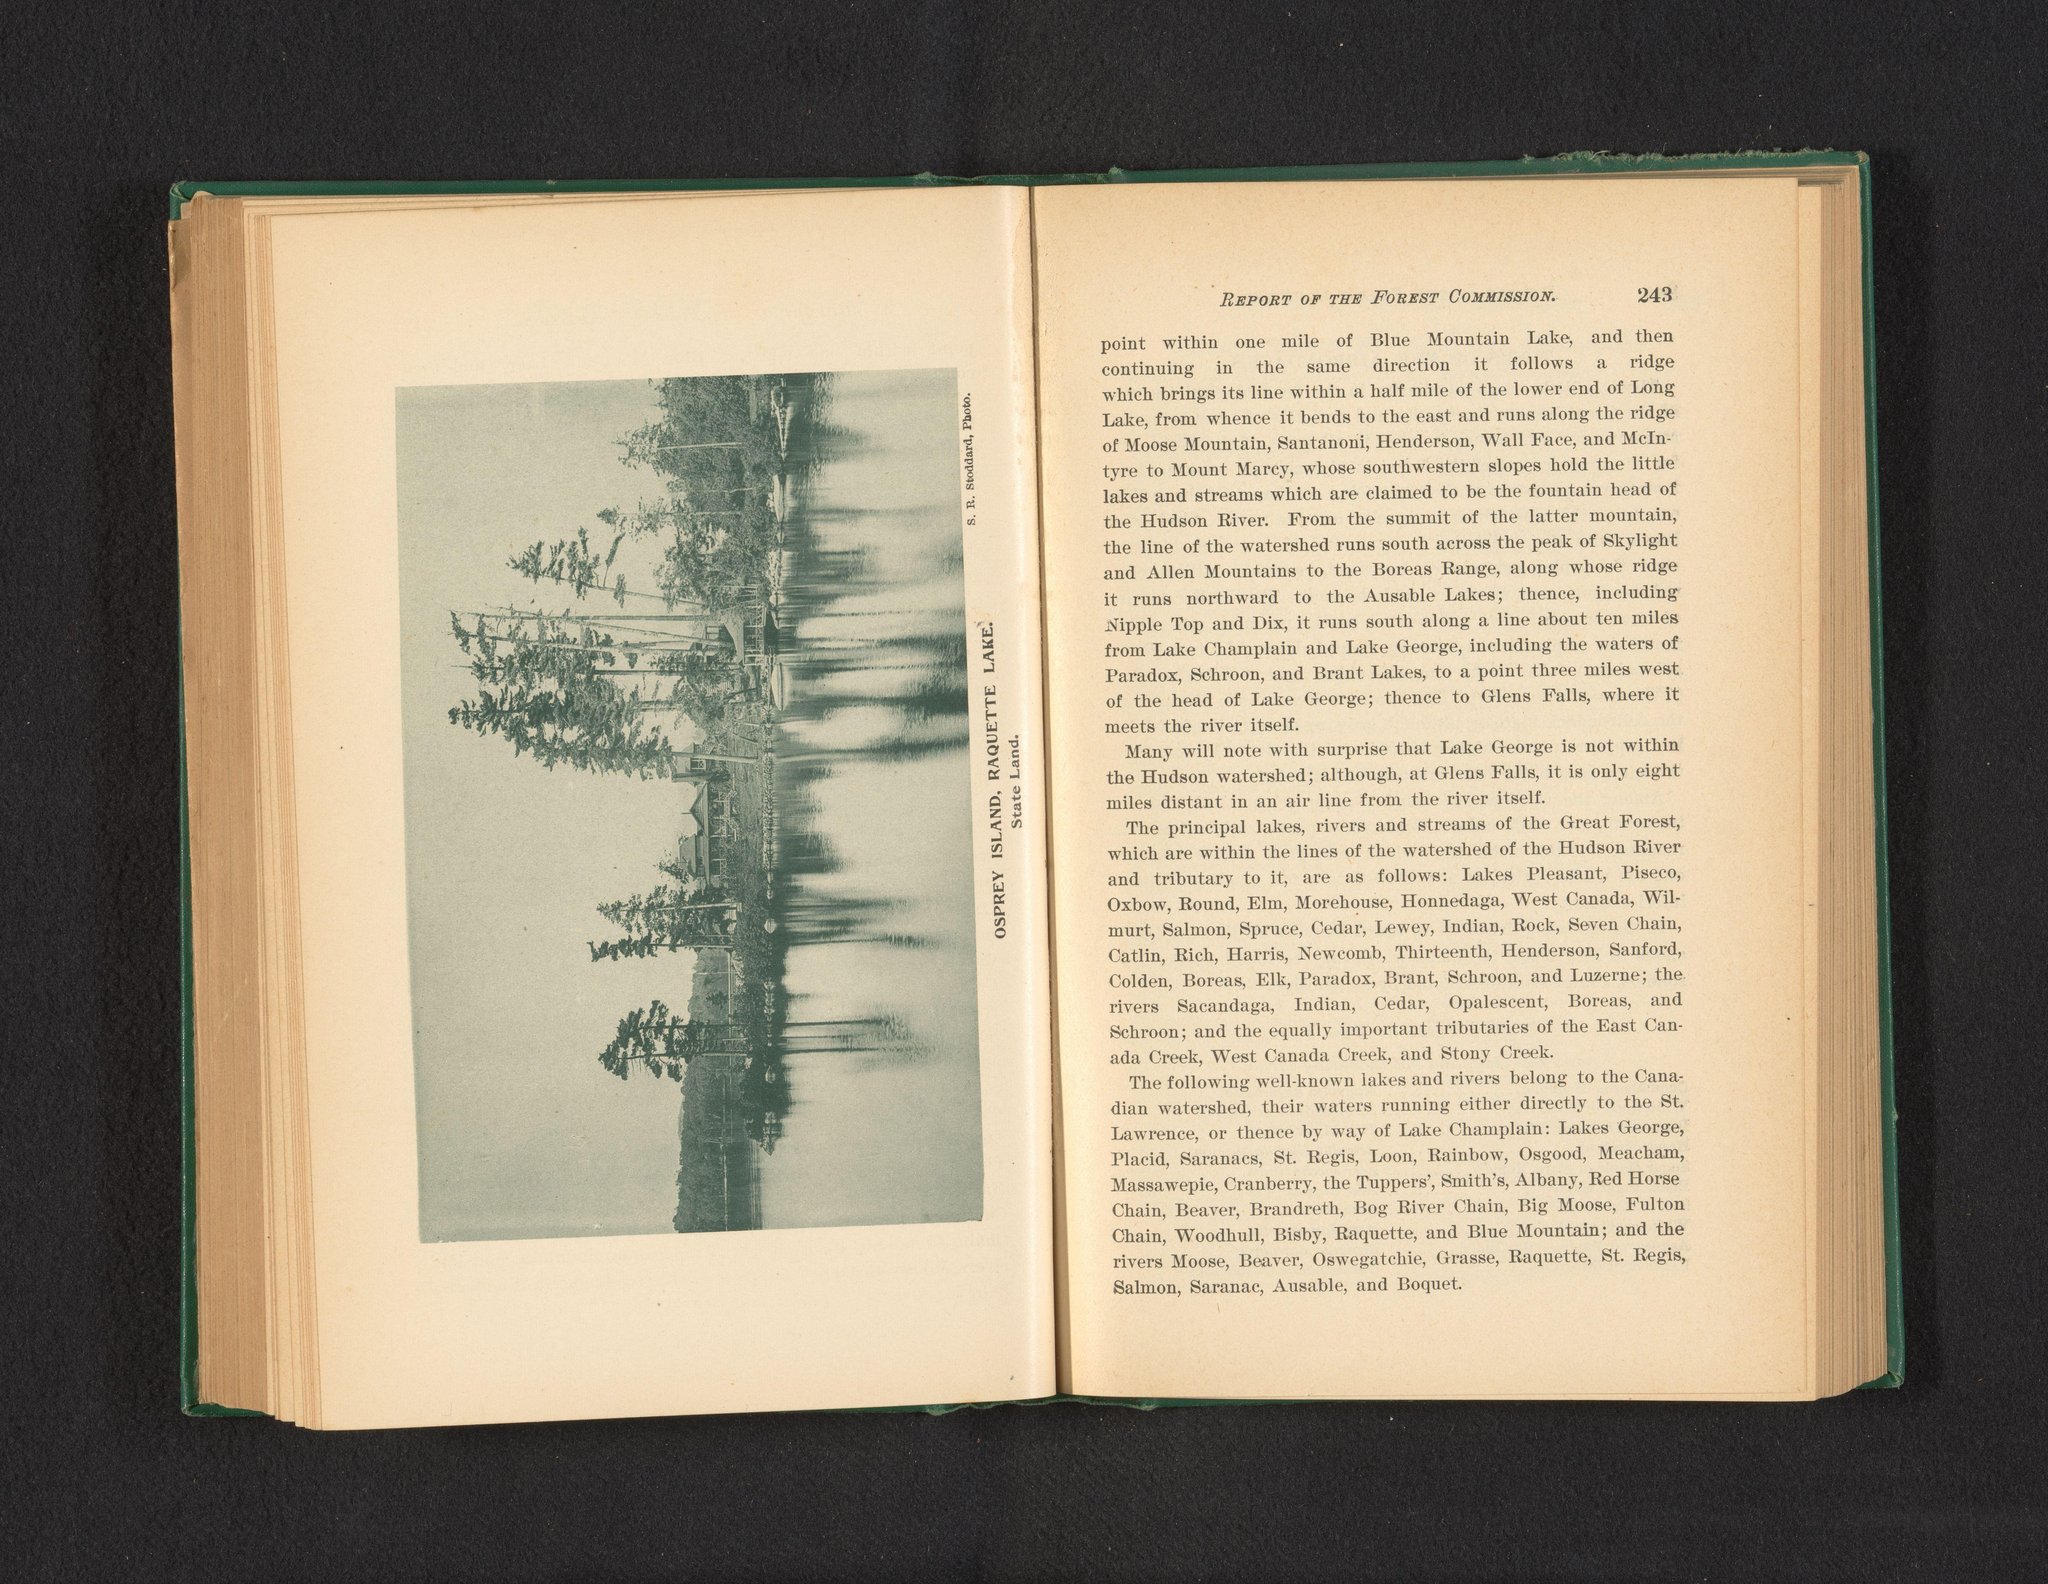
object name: photomechanical print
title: Osprey Island, Raquette Lake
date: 1893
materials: paper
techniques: photograph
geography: new york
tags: island, lake